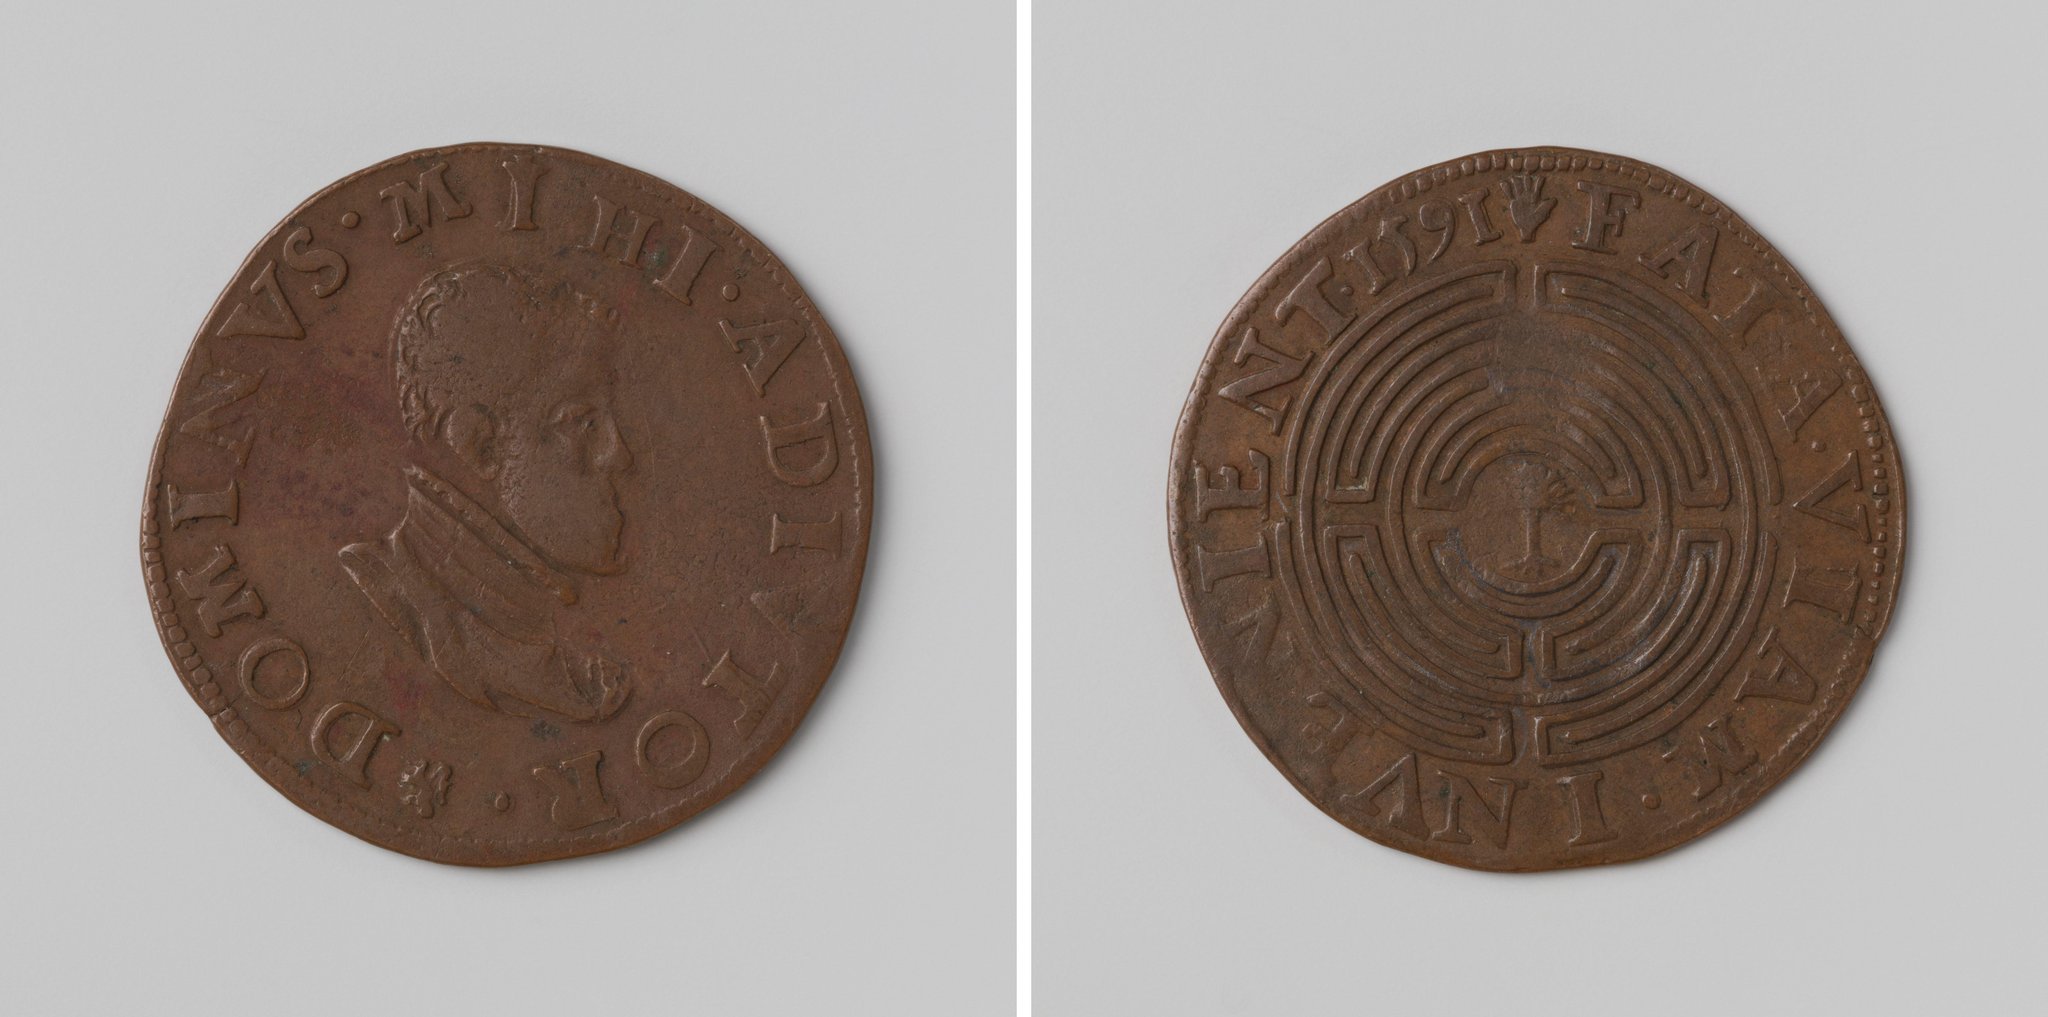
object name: jeton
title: Filips II, koning van Spanje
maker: Anonymous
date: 1591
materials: copper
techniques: striking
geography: antwerp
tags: philip ii of spain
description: Koperen penning. Voorzijde: borststuk man binnen omschrift. Keerzijde: boom in labyrinth binnen omschrift